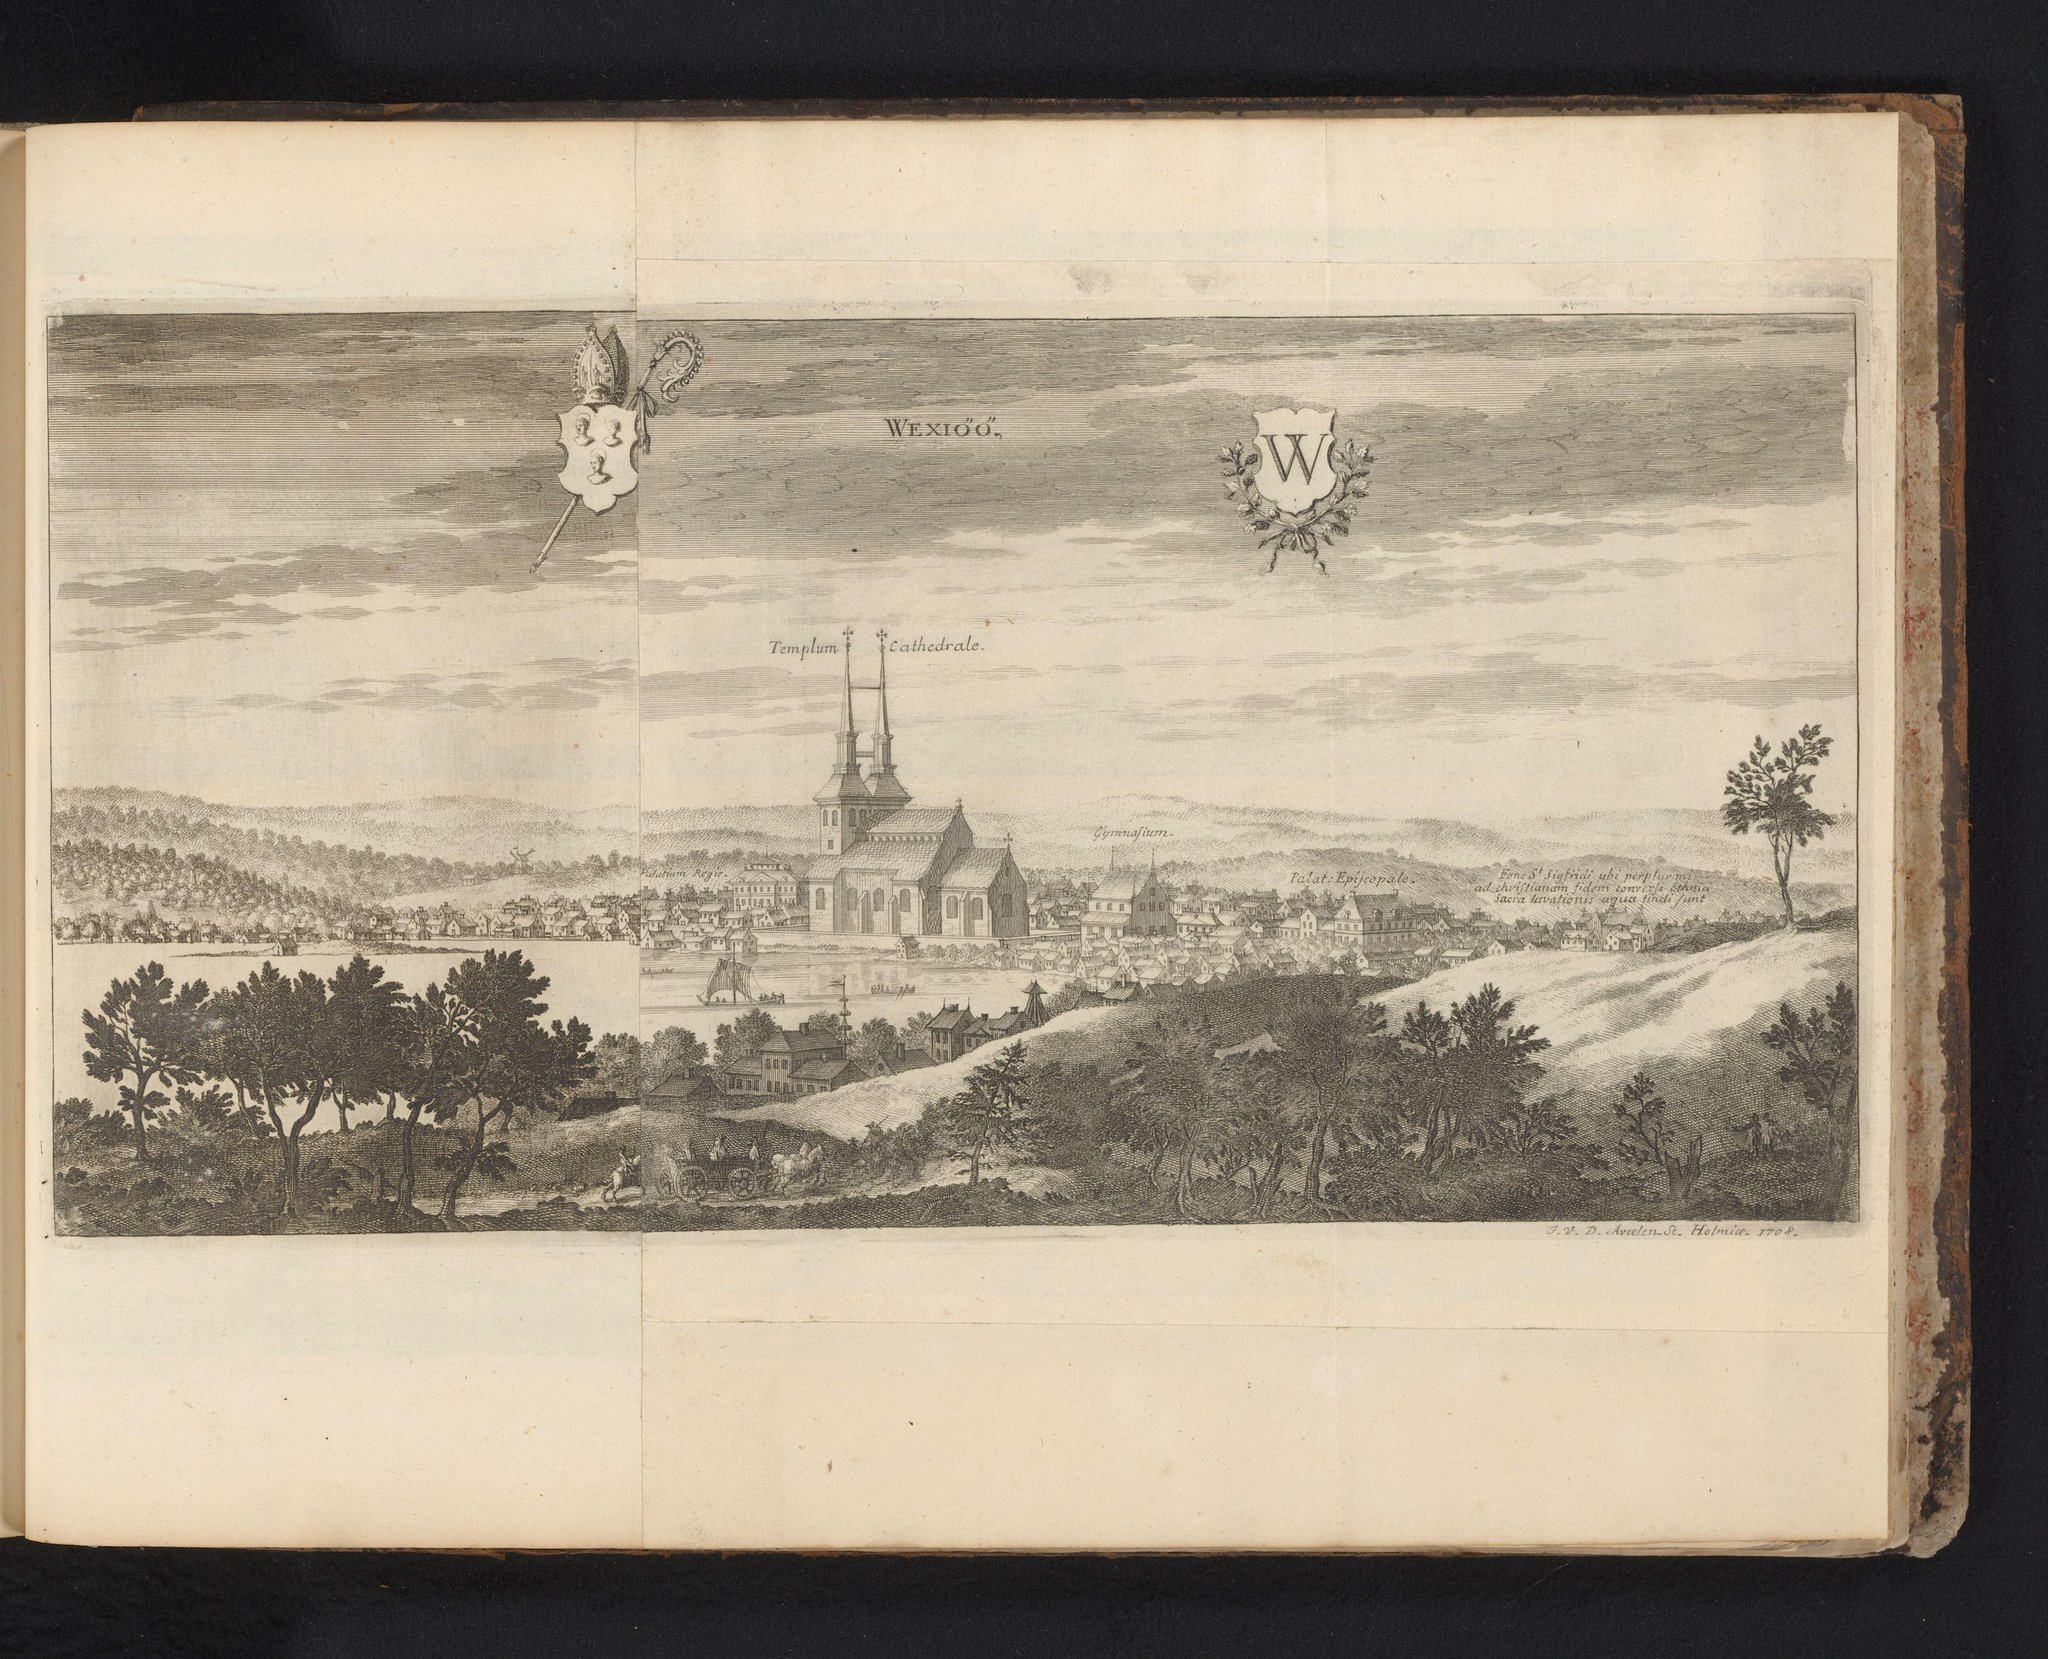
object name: album leaf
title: Suecia Antiqua et Hodierna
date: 1708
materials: paper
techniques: etching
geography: stockholm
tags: city-view in general; 'veduta'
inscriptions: date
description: Kungliga Biblioteket, 'Suecia': http://www.kb.se/samlingarna/Kartor-bilder/Suecia-antiqua/ (geraadpleegd november 2016).